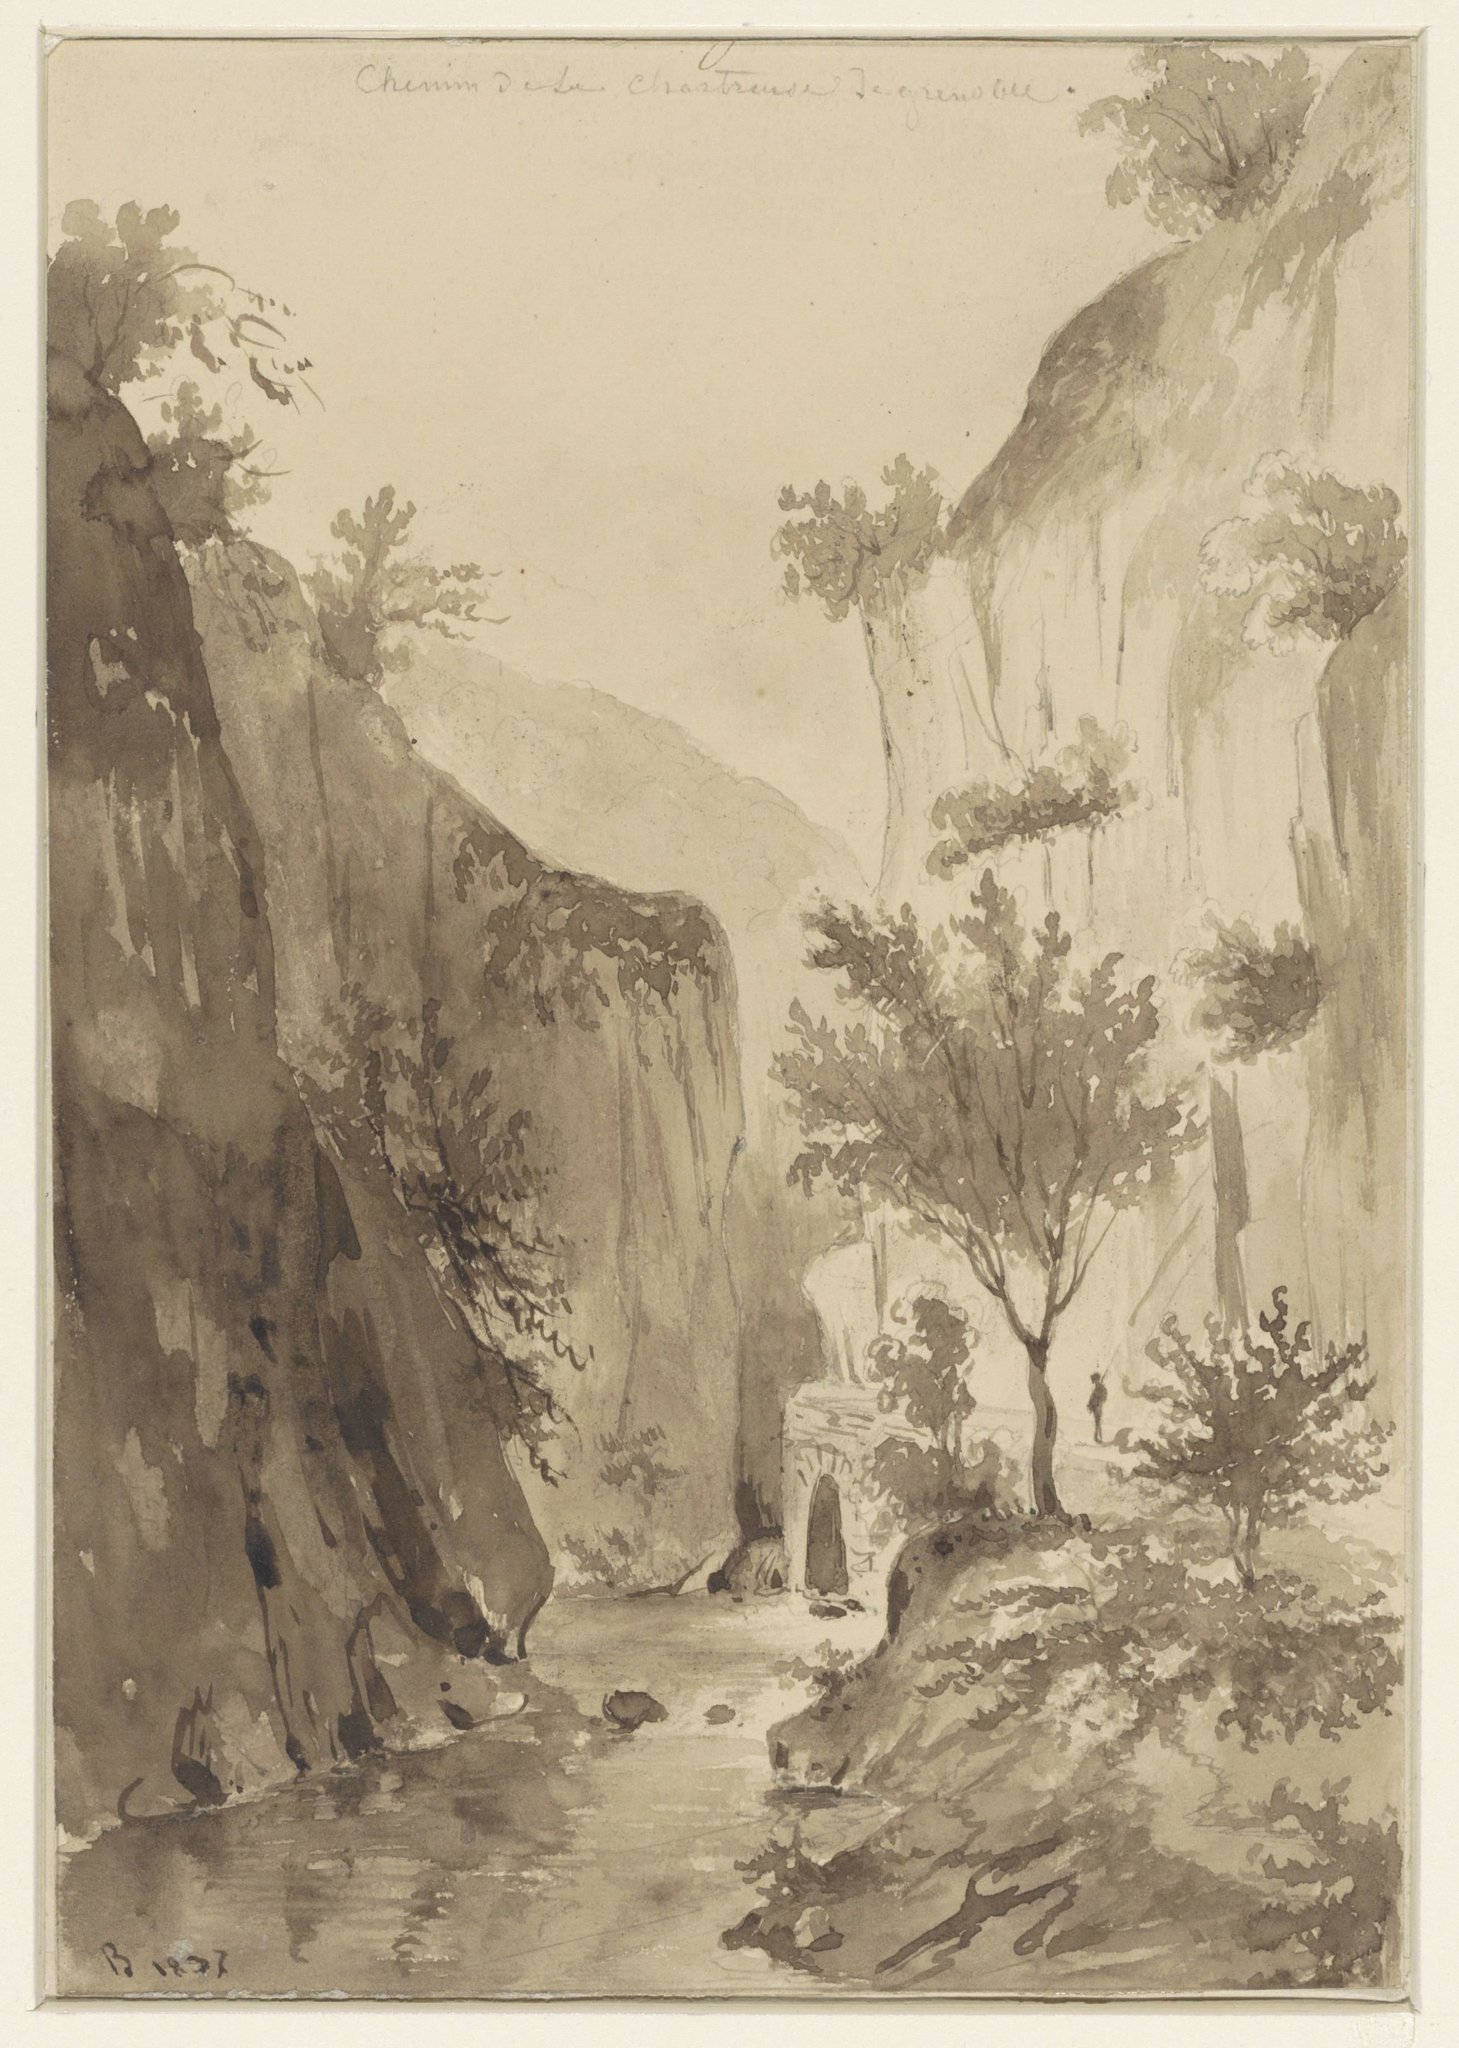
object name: drawing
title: Rivier tussen begroeide rotsen; rechts een weg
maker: a regnier (nthony?)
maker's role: draughtsman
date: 1837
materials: paper, pencil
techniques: brush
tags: ravine, chasm, abyss, canyon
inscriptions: date: ‘1837’, inscription: ‘Chemin de la Chartreuse Val d'Isère’